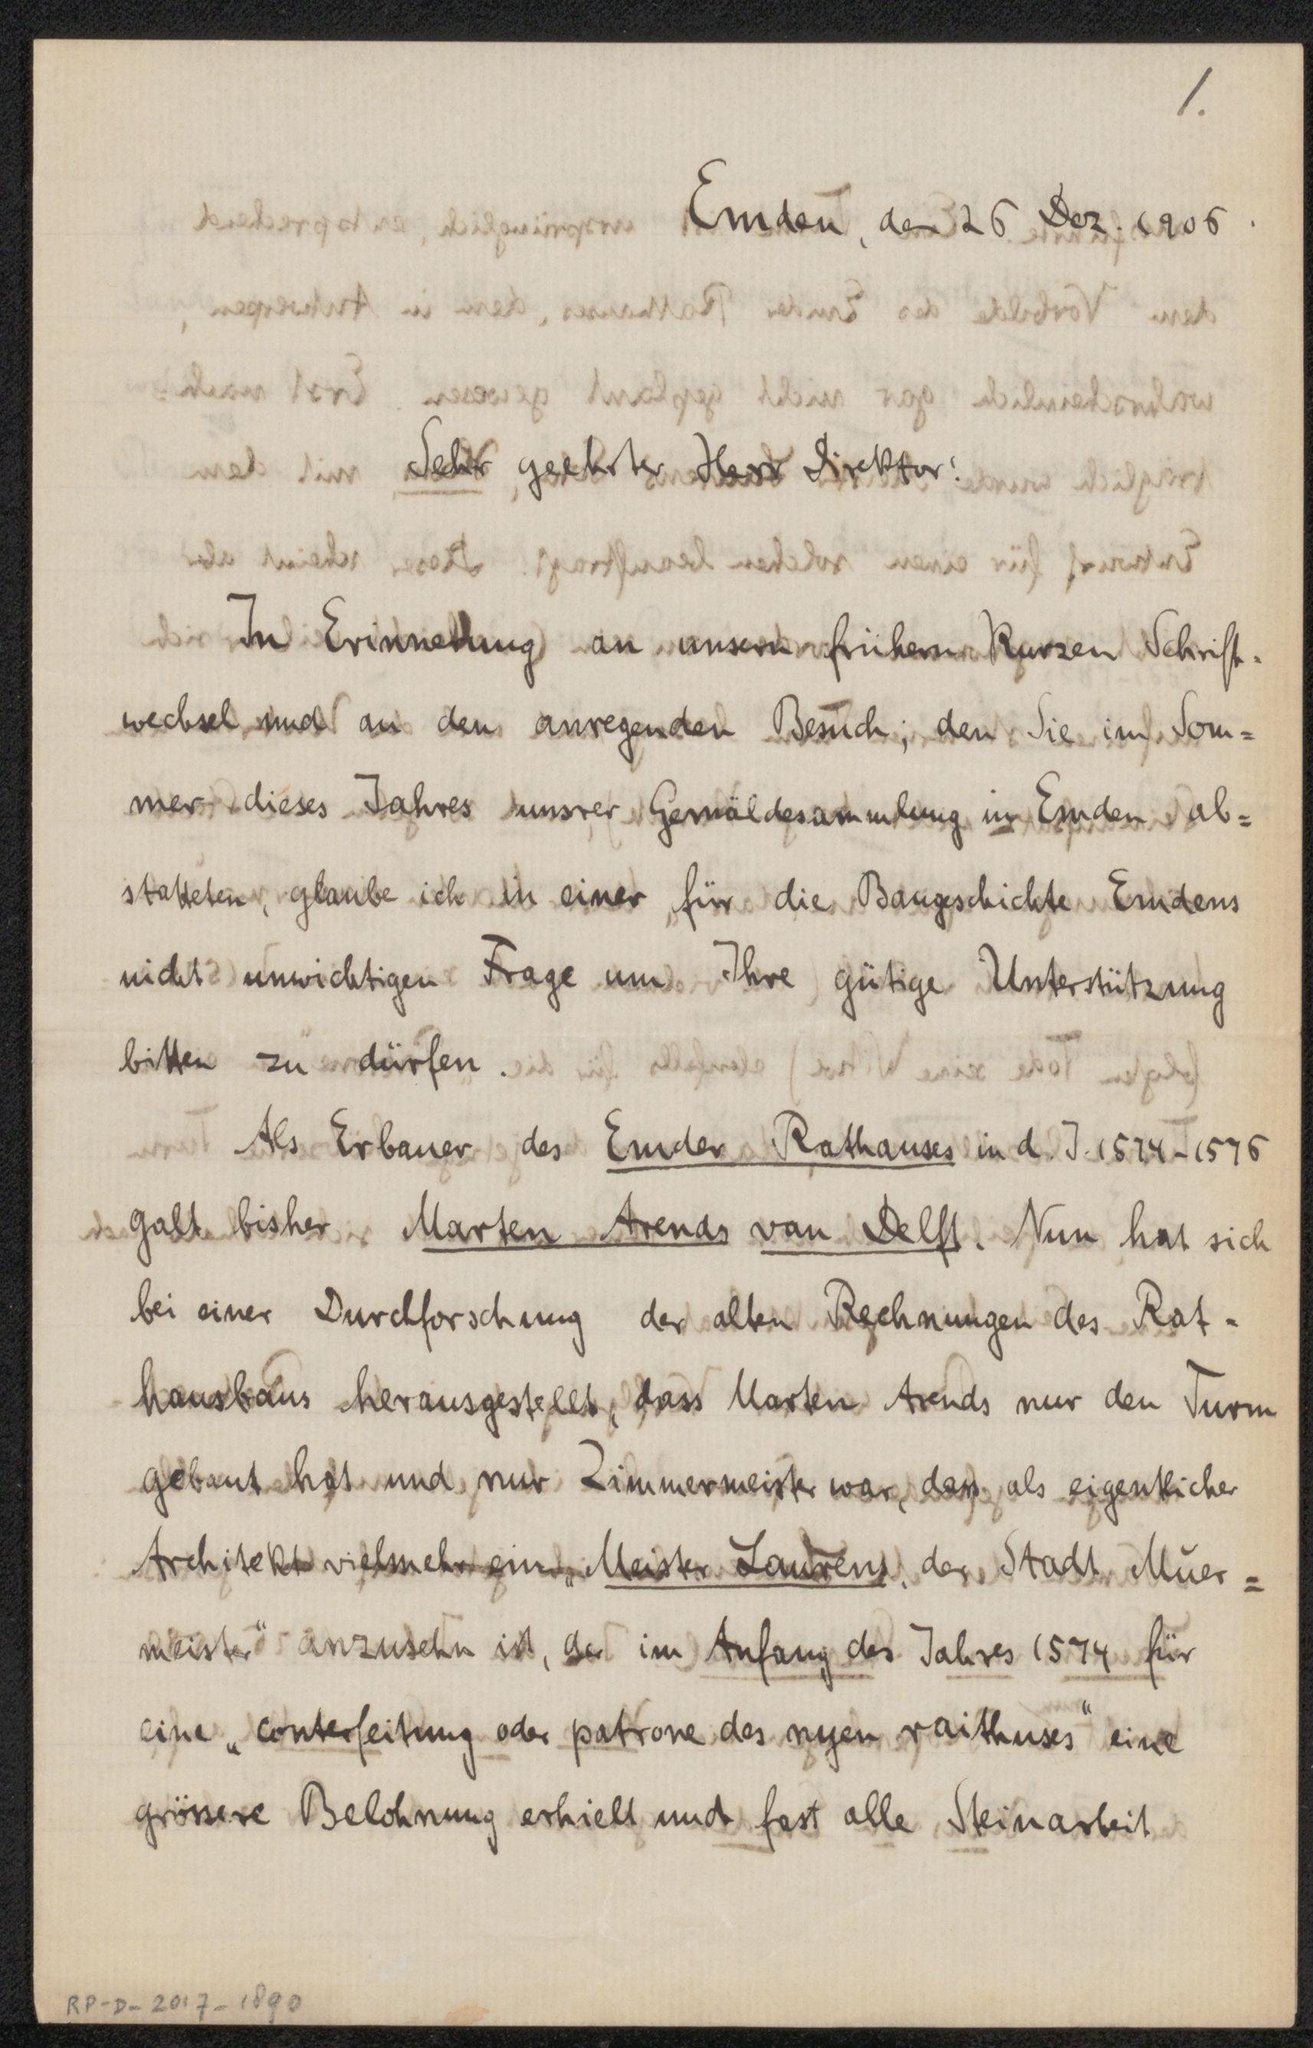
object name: letter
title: Brief aan Pieter Haverkorn van Rijsewijk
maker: f. ritter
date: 1905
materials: ink, paper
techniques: pen, writing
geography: emden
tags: antwerp, engineer, pieter haverkorn van rijsewijk, painting (including book-illumination, miniature-painting), architecture